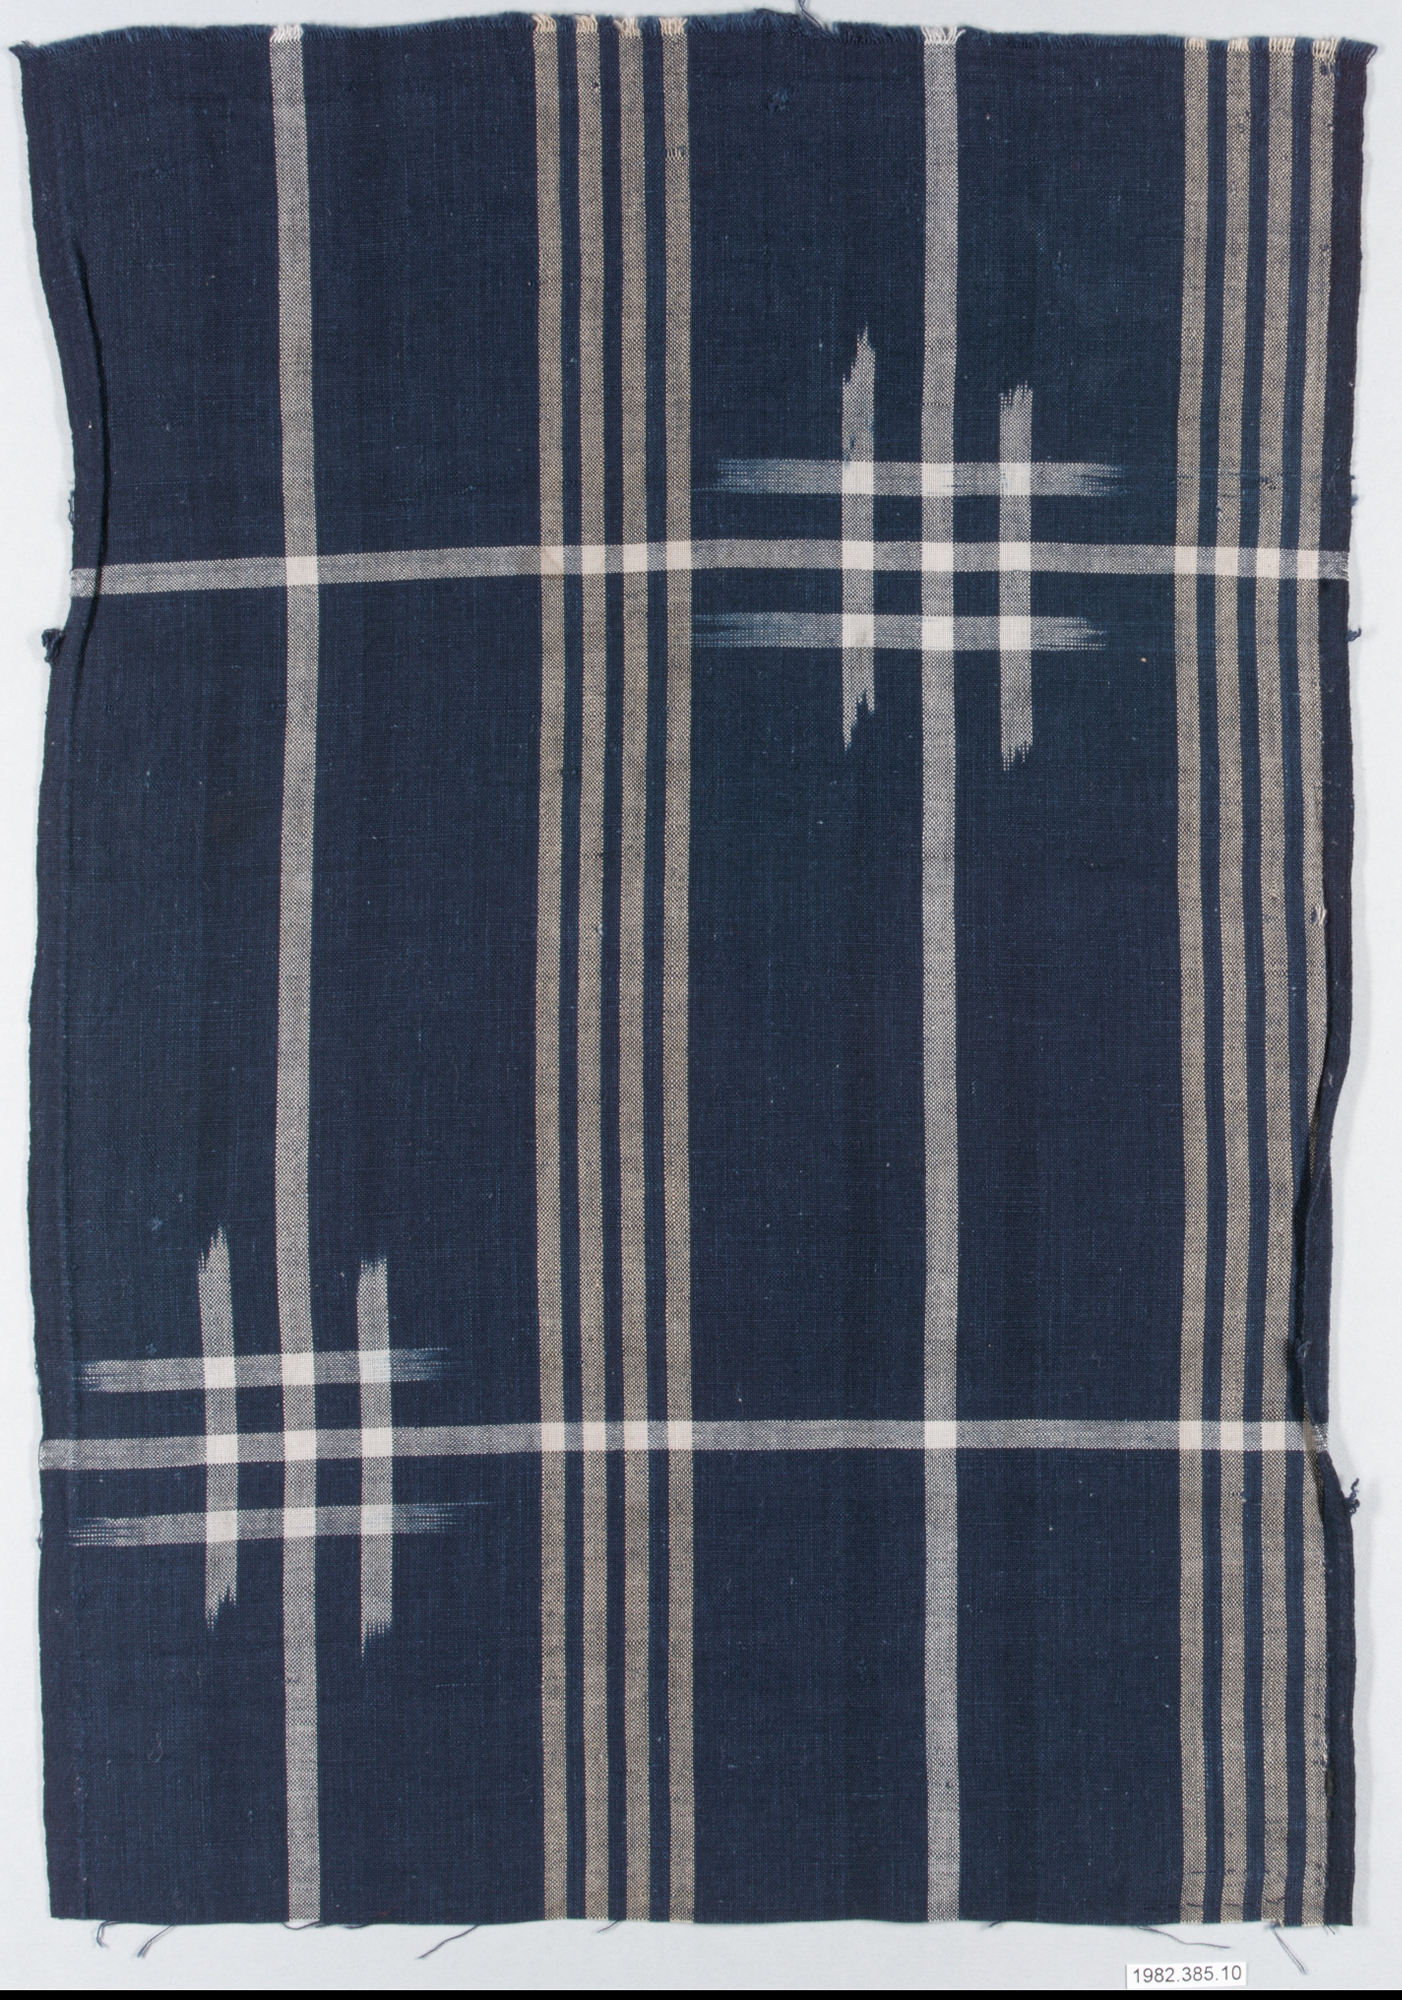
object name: piece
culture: japanese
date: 1868-1926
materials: cotton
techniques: dyeing